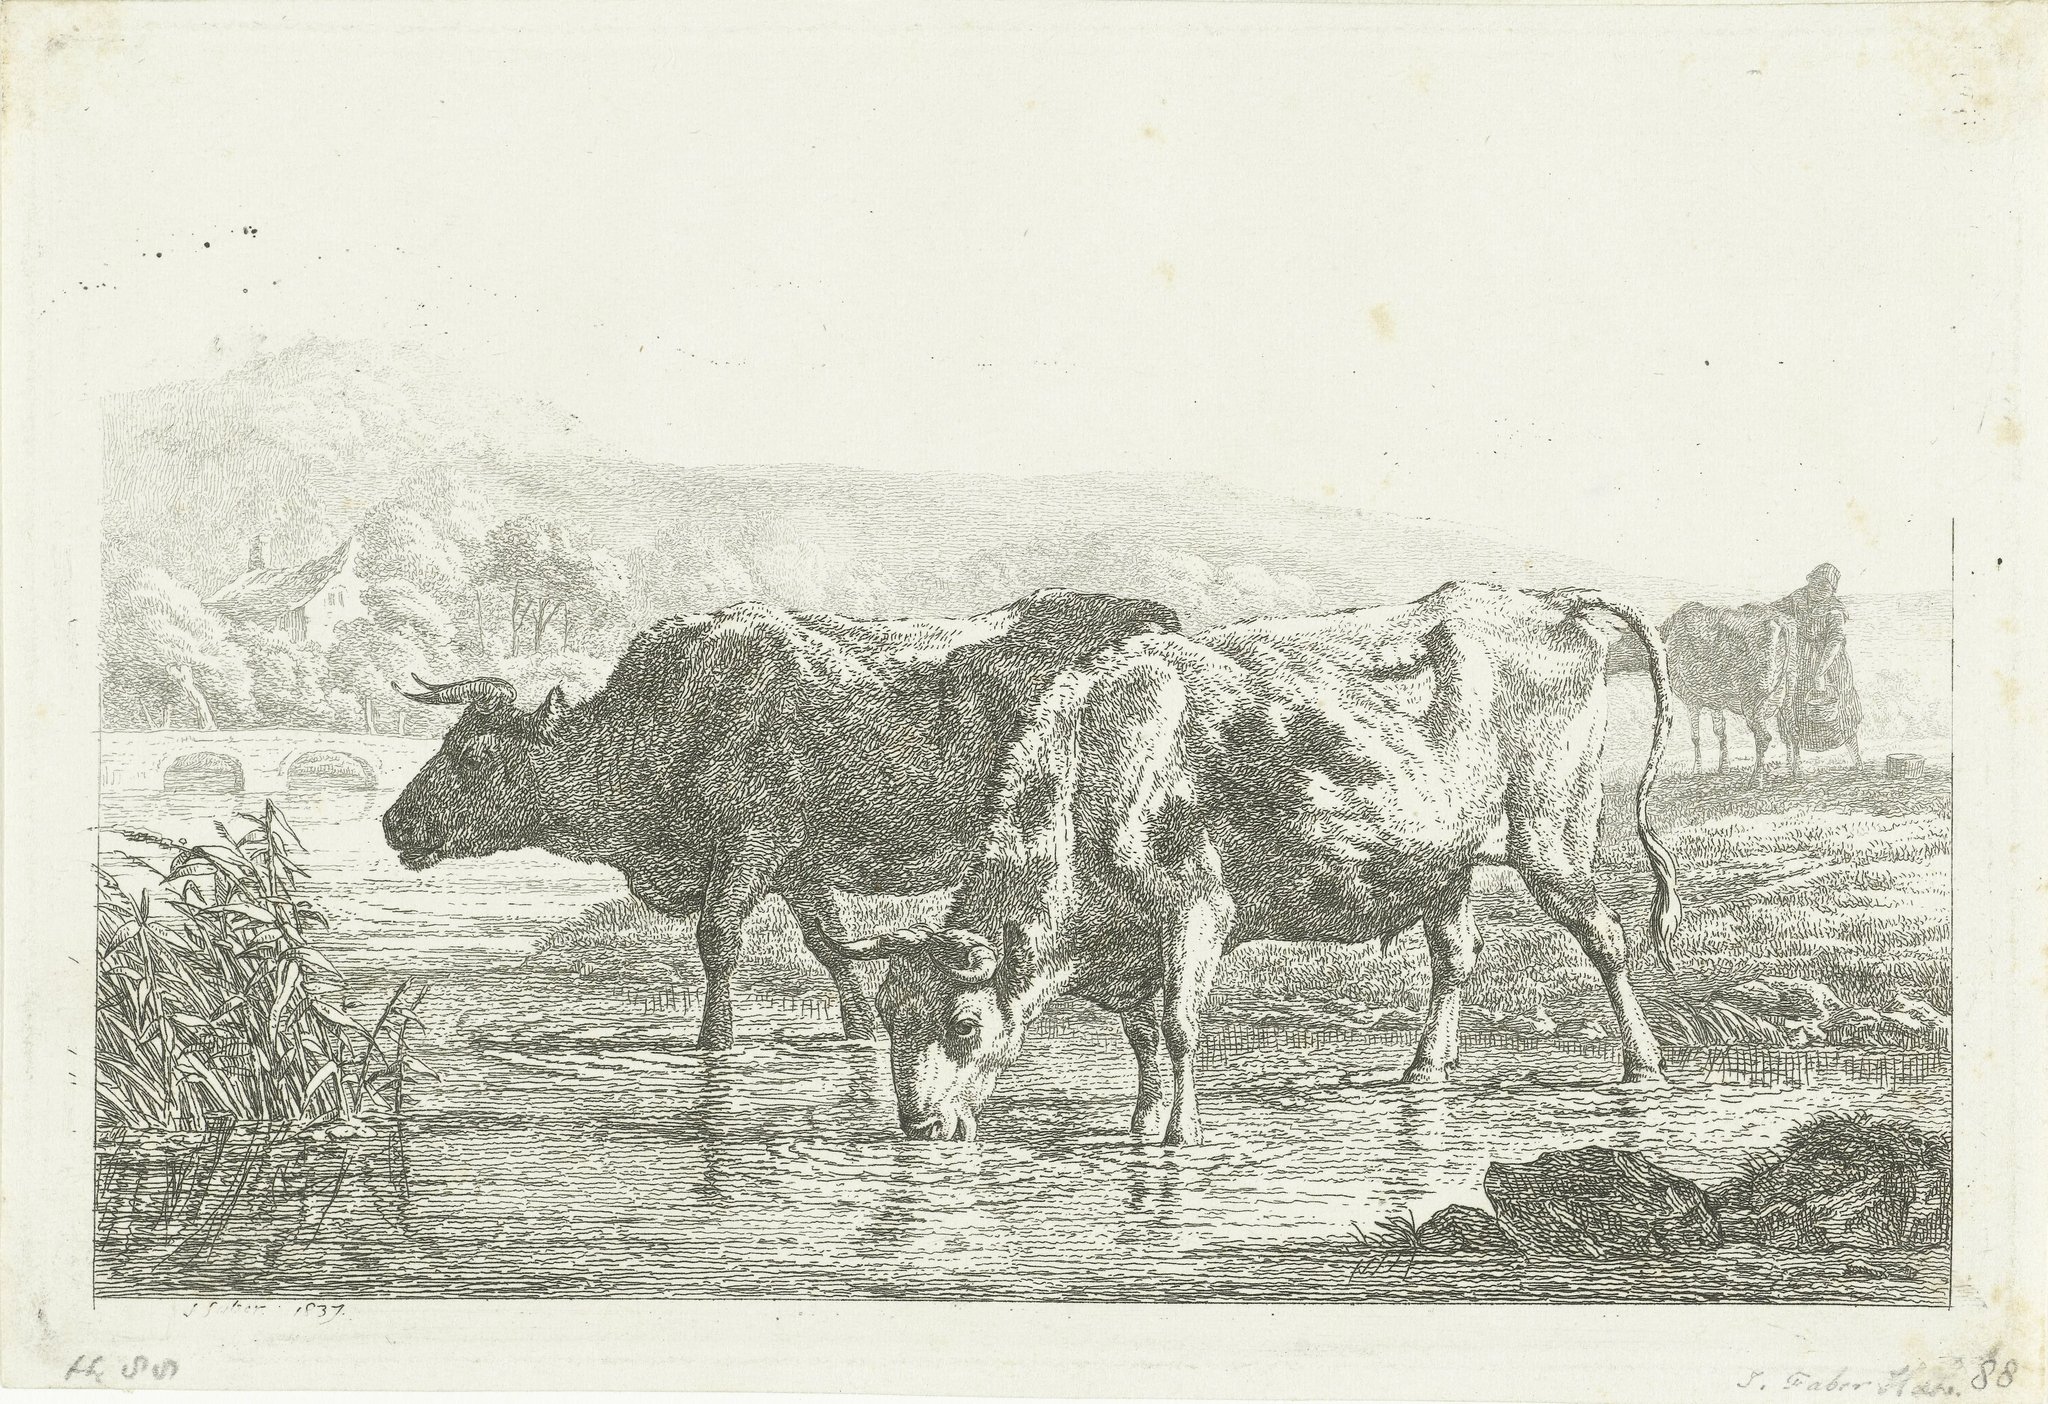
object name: print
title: Twee drinkende koeien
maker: frédéric théodore faber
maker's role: print maker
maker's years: 1782-1844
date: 1837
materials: paper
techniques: etching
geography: brussels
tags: cow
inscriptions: date